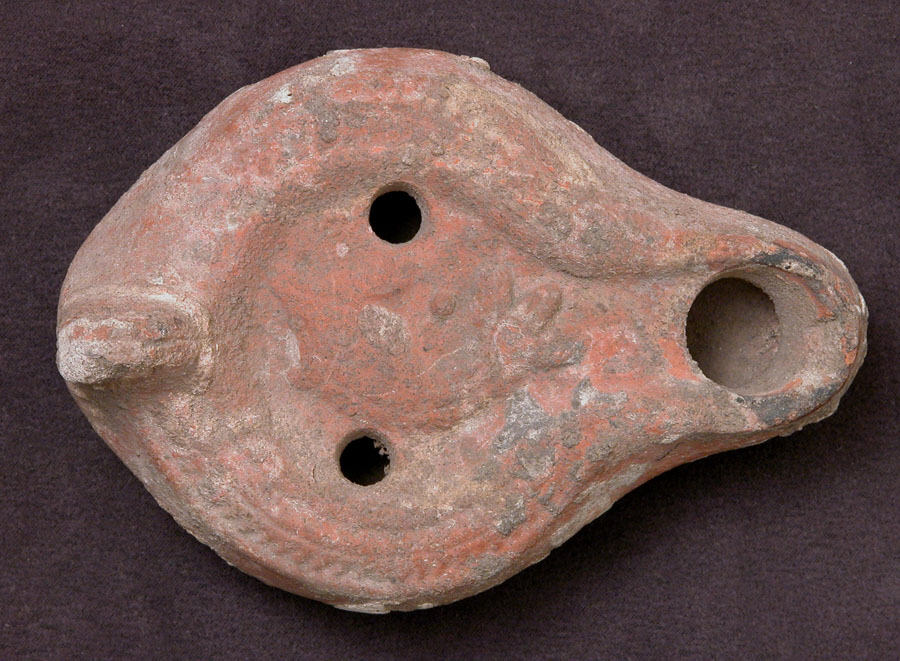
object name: lamp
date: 301-400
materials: earthenware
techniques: molding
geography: egypt